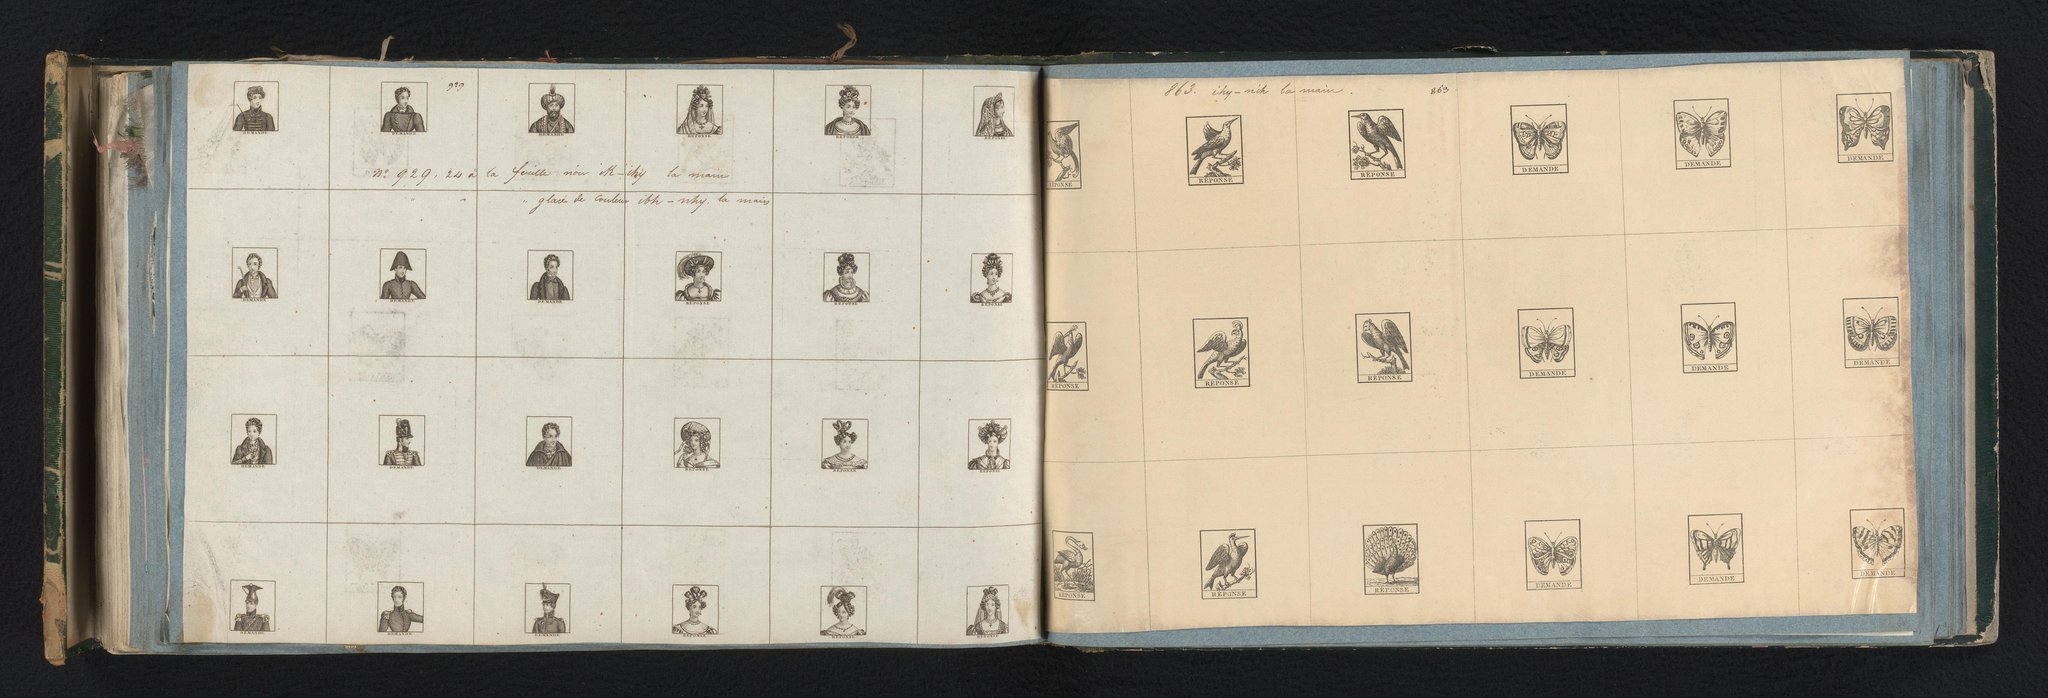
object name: sample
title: Twee bladzijden met bladen met vignetten met mannen en vrouwen en vlinders en vogels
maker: Anonymous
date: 1830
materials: ink, paper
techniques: etching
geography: france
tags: birds, insects: butterfly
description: Twee bladzijden met links een ingeplakt blad waarop 24 gedrukte vignetten van bustes van vrouwen met opschrift 'reponse' en mannen met opschrift 'demande'. Rechts een ingeplakt blad met 18 gedrukte vignetten van vogels met opschrift 'reponse' en vlinders met opschrift 'demande'. Zonder de etiketten met nummers, maar de bladen genummerd 939 en 863 en voorzien van handgeschreven codes. Onderdeel van het stalenboek geschonken door de dames Van Rijn, vermoedelijk van een Franse papierfabrikant van luxe papieren, of diens vertegenwoordiger in Nederland, ca. 1830.